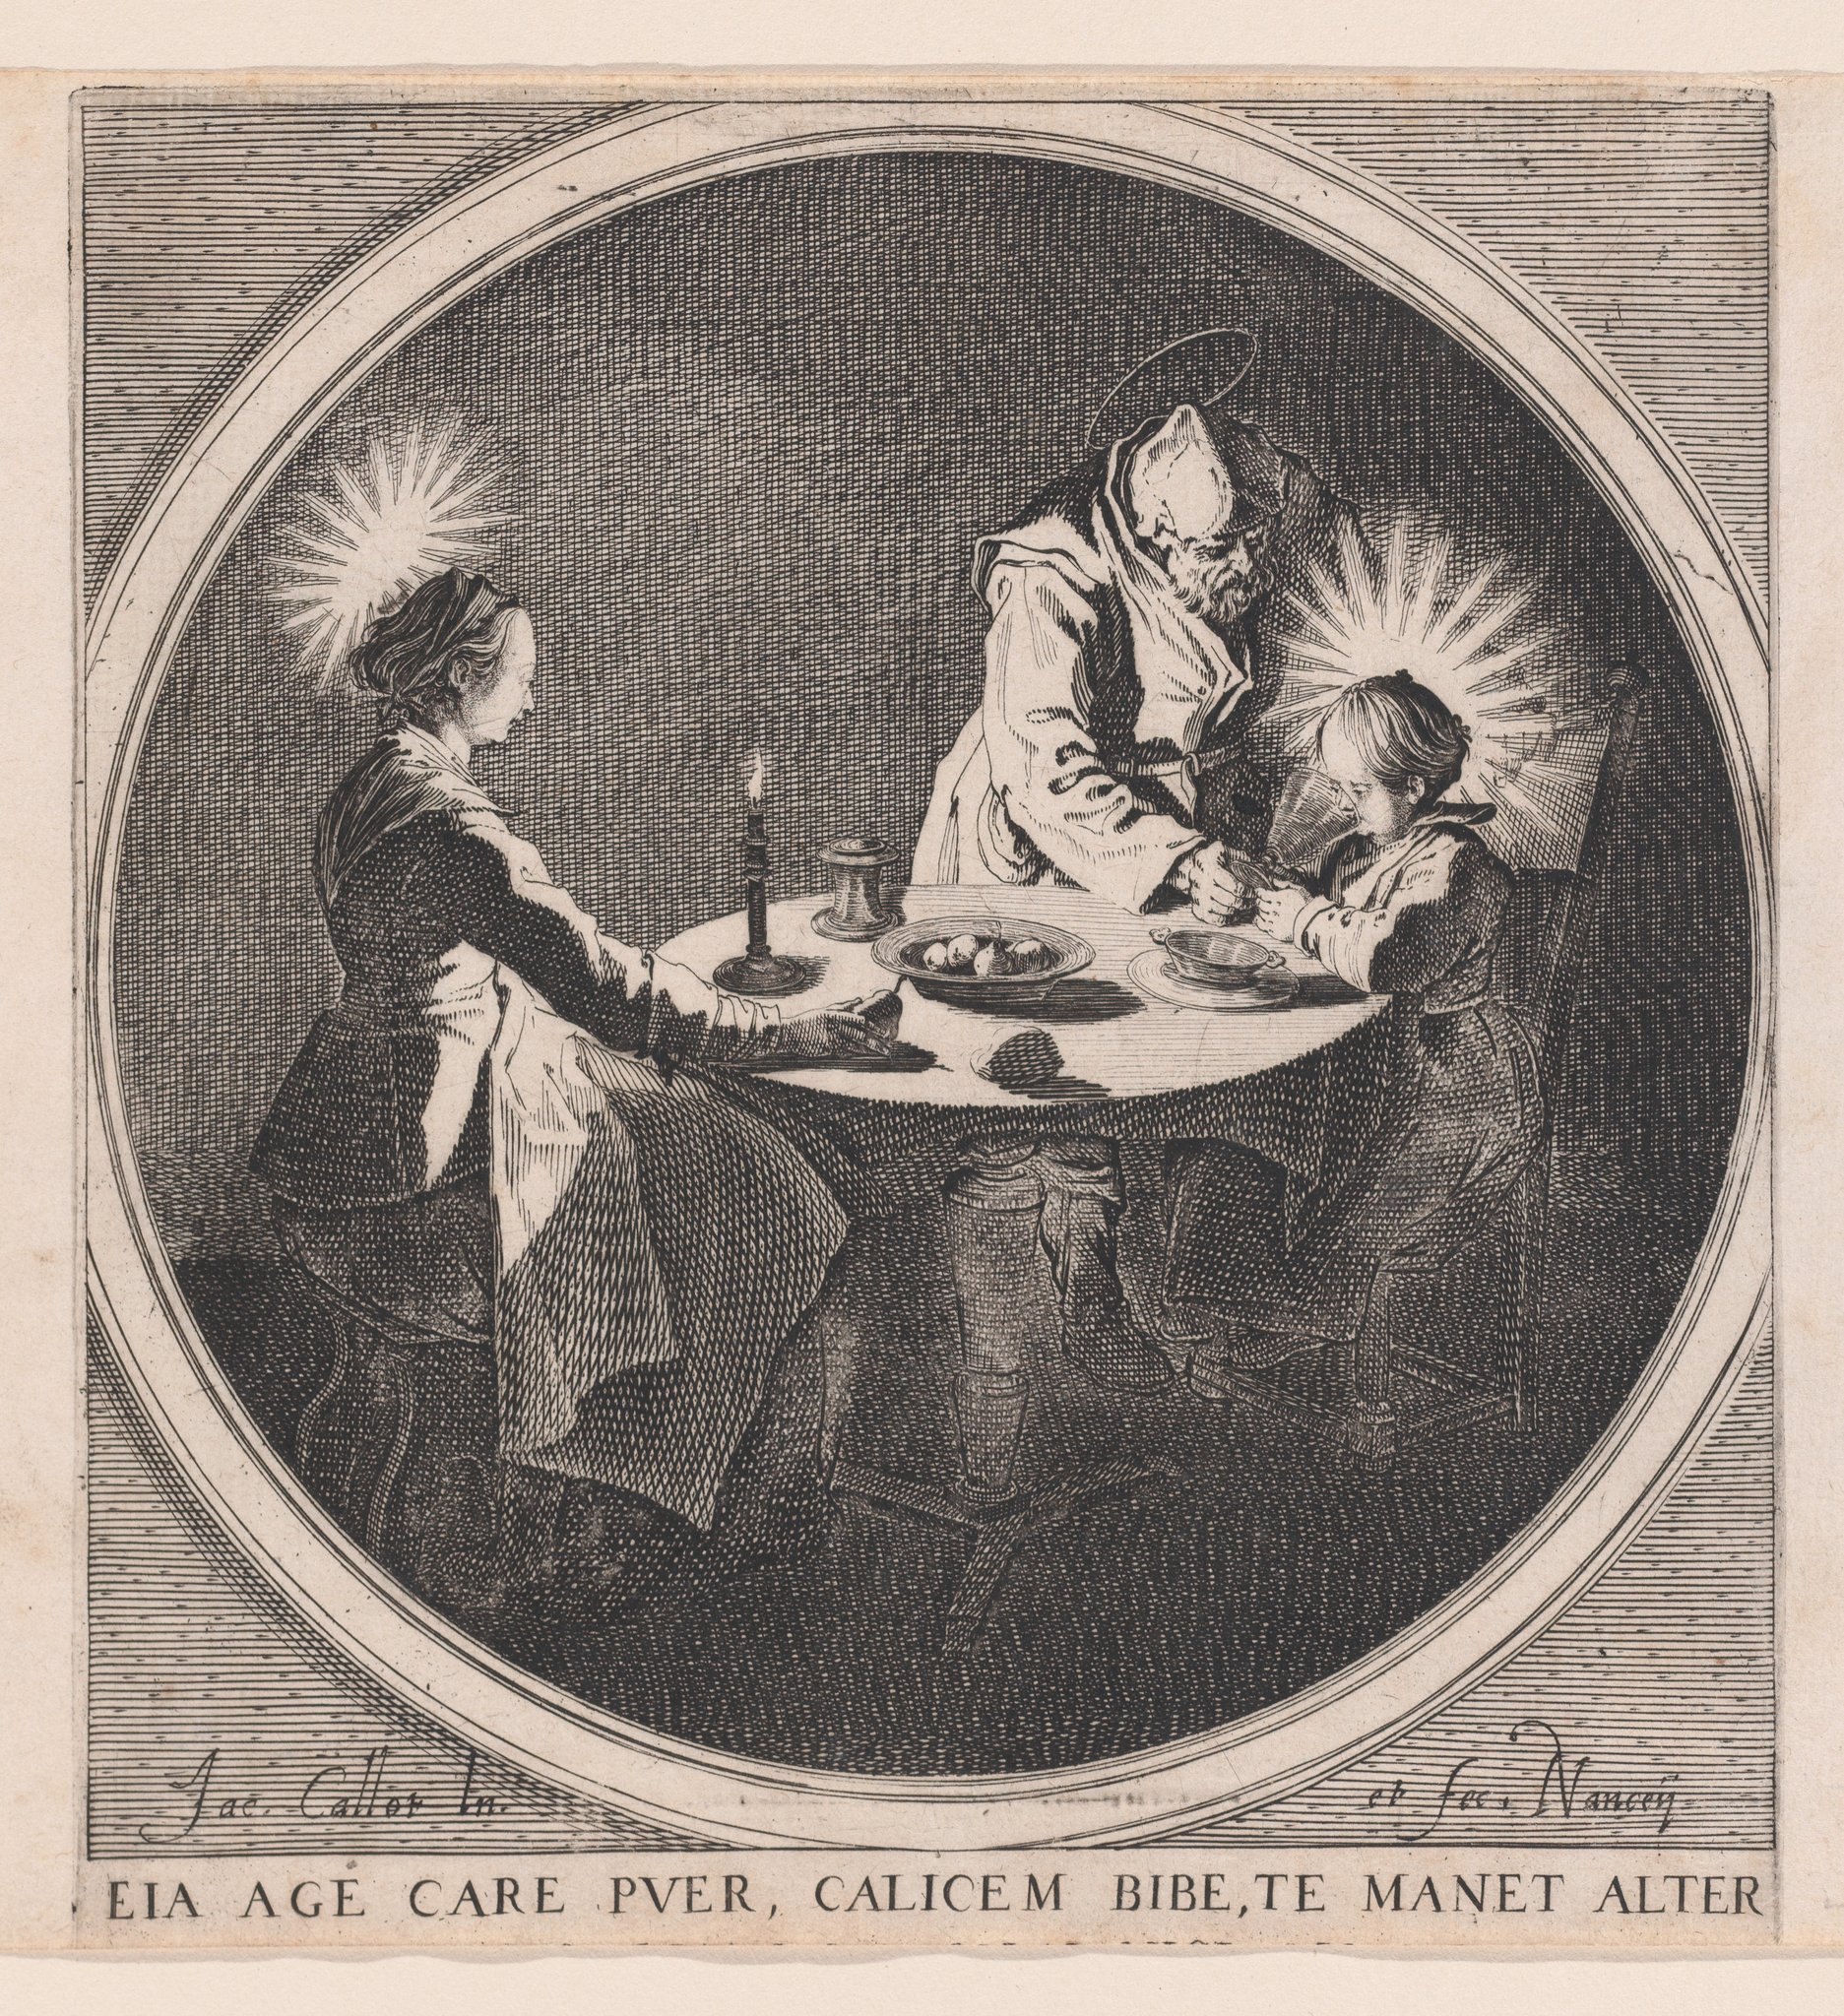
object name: print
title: Le Benedicite, estampe appelée aussi La Sainte Famille a Table et St. Joseph Faisant Boire L'Enfant Jésus (The Grace, also called The Holy Family at the Table and St. Joseph Giving the Christ Child a Drink)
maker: jacques callot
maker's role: artist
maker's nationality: french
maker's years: 1592-1635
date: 1601-1633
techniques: engraving, etching